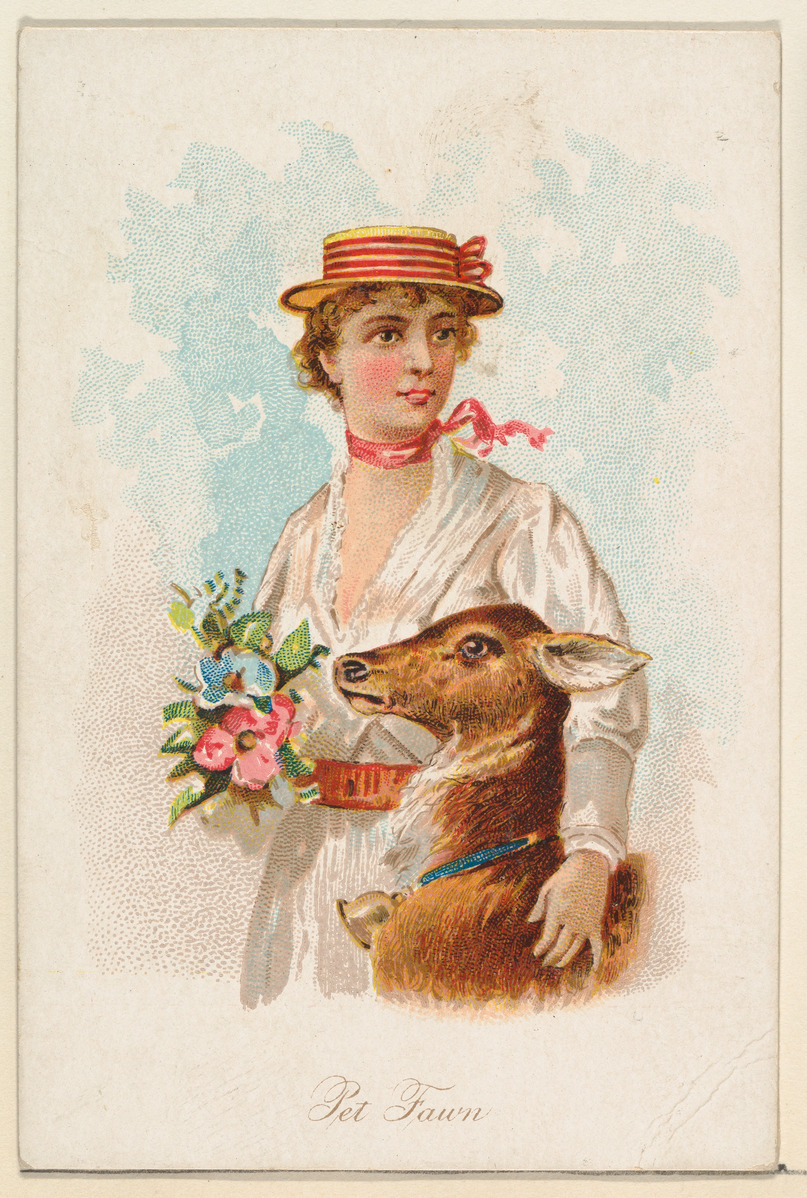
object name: print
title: Pet Fawn, from the Household Pets series (N194) issued by Wm. S. Kimball & Co.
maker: william s. kimball & company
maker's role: publisher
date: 1891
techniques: color lithograph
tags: women,deer